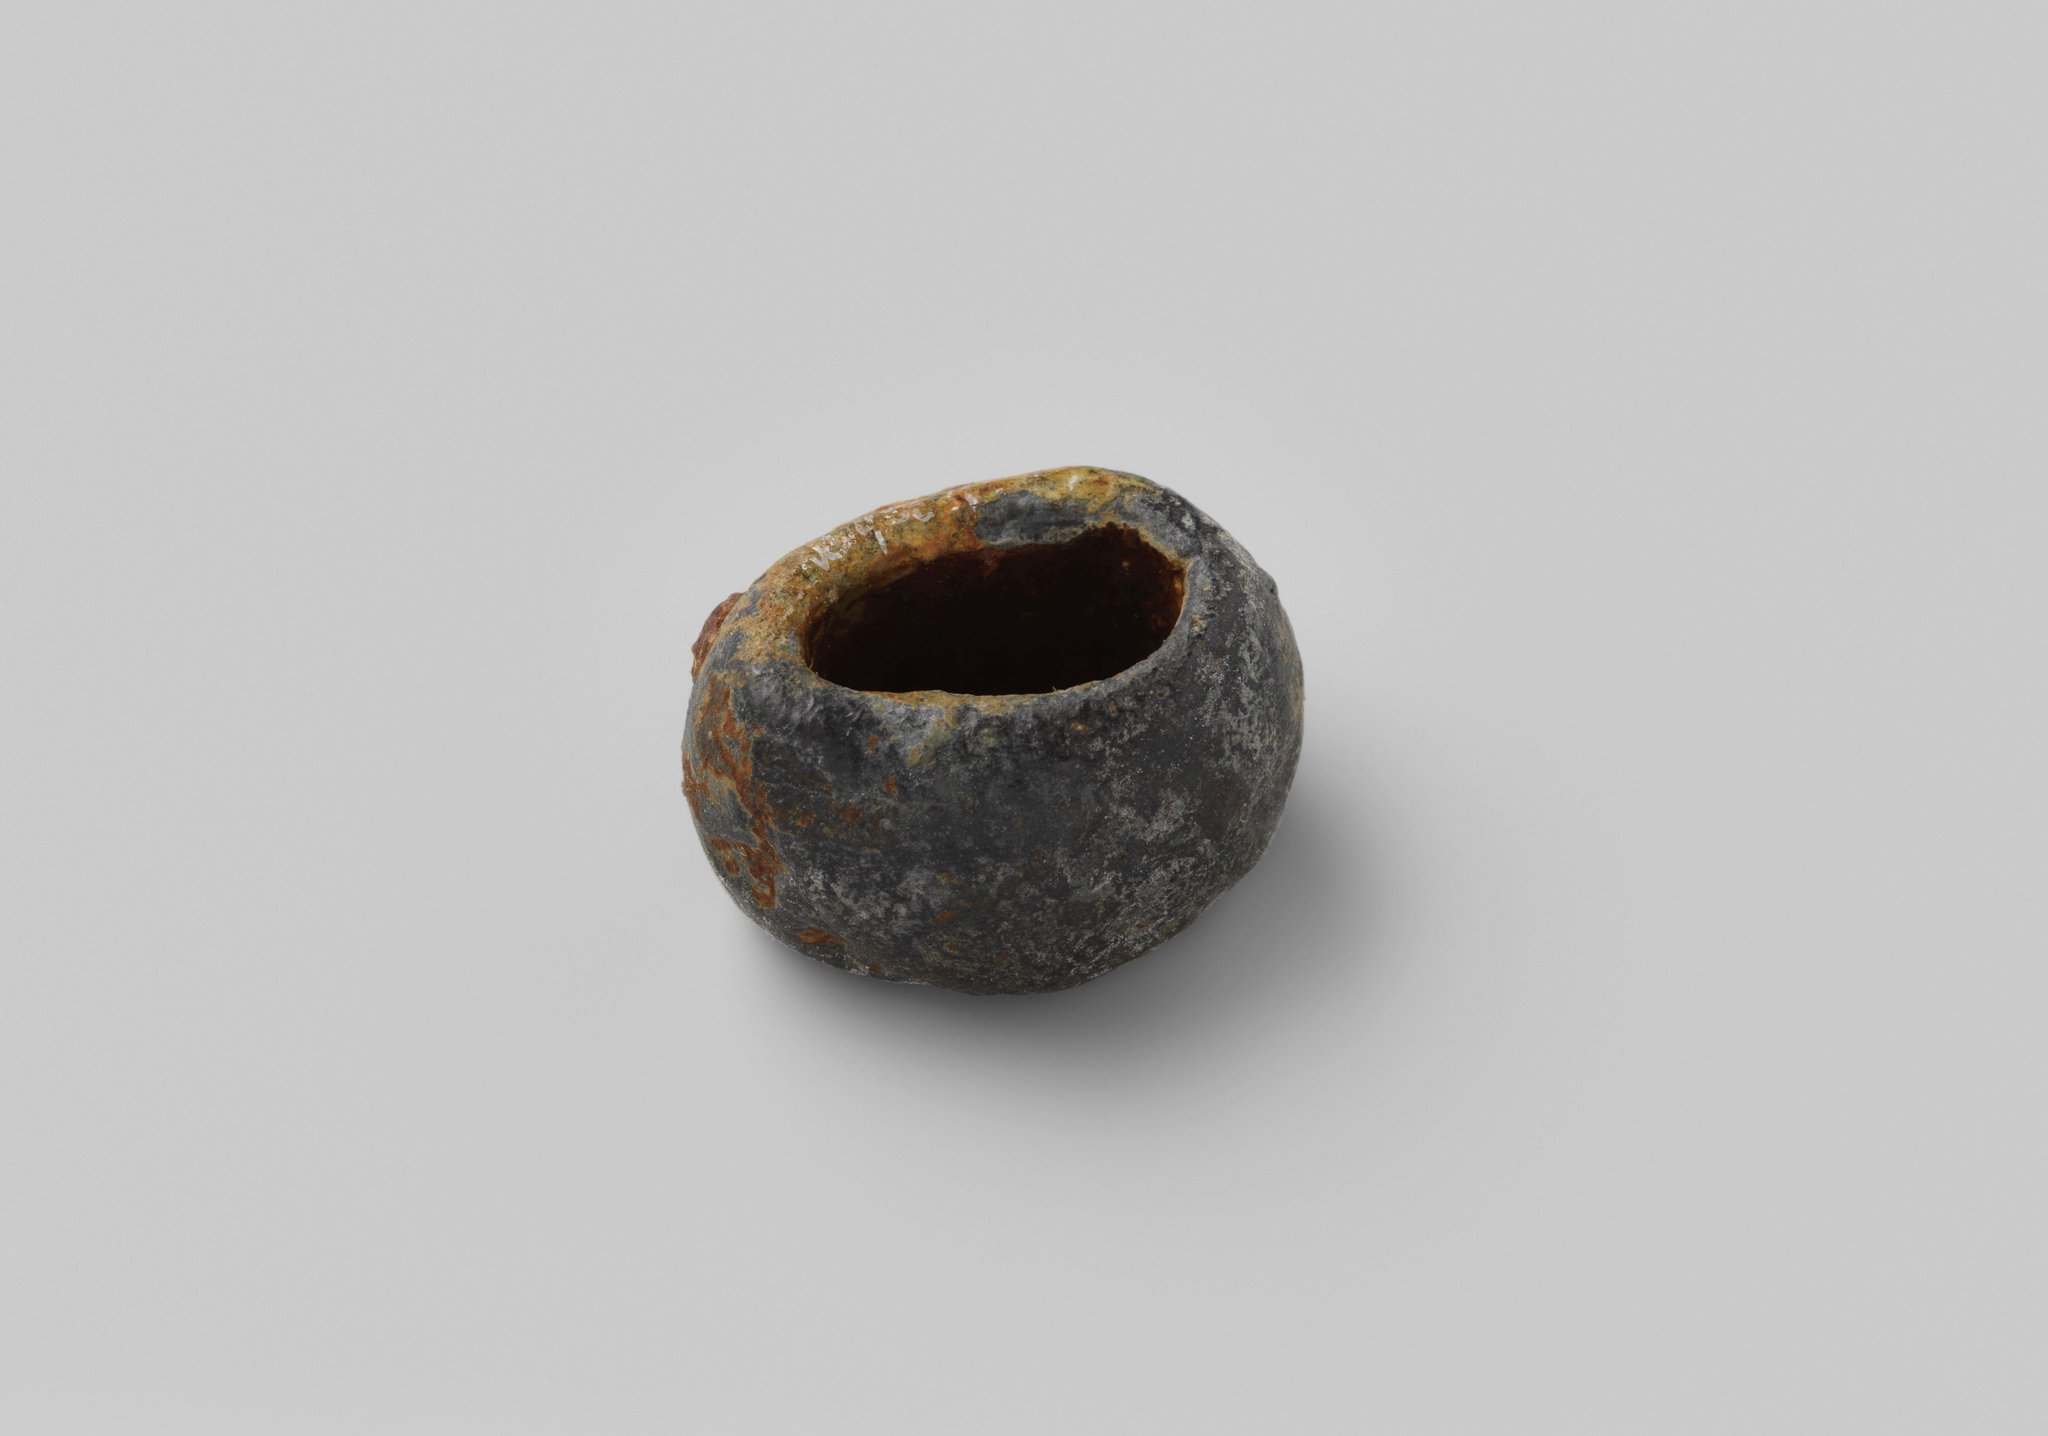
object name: ring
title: Ringvormig fragment uit het wrak van de Oost-Indiëvaarder Hollandia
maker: Anonymous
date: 1700-1743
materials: lead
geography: netherlands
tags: verenigde oostindische compagnie, hollandia (schip), annet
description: Varied parts or fragments, rings and ring-shaped fragments; head-shaped, oval, convex outside.